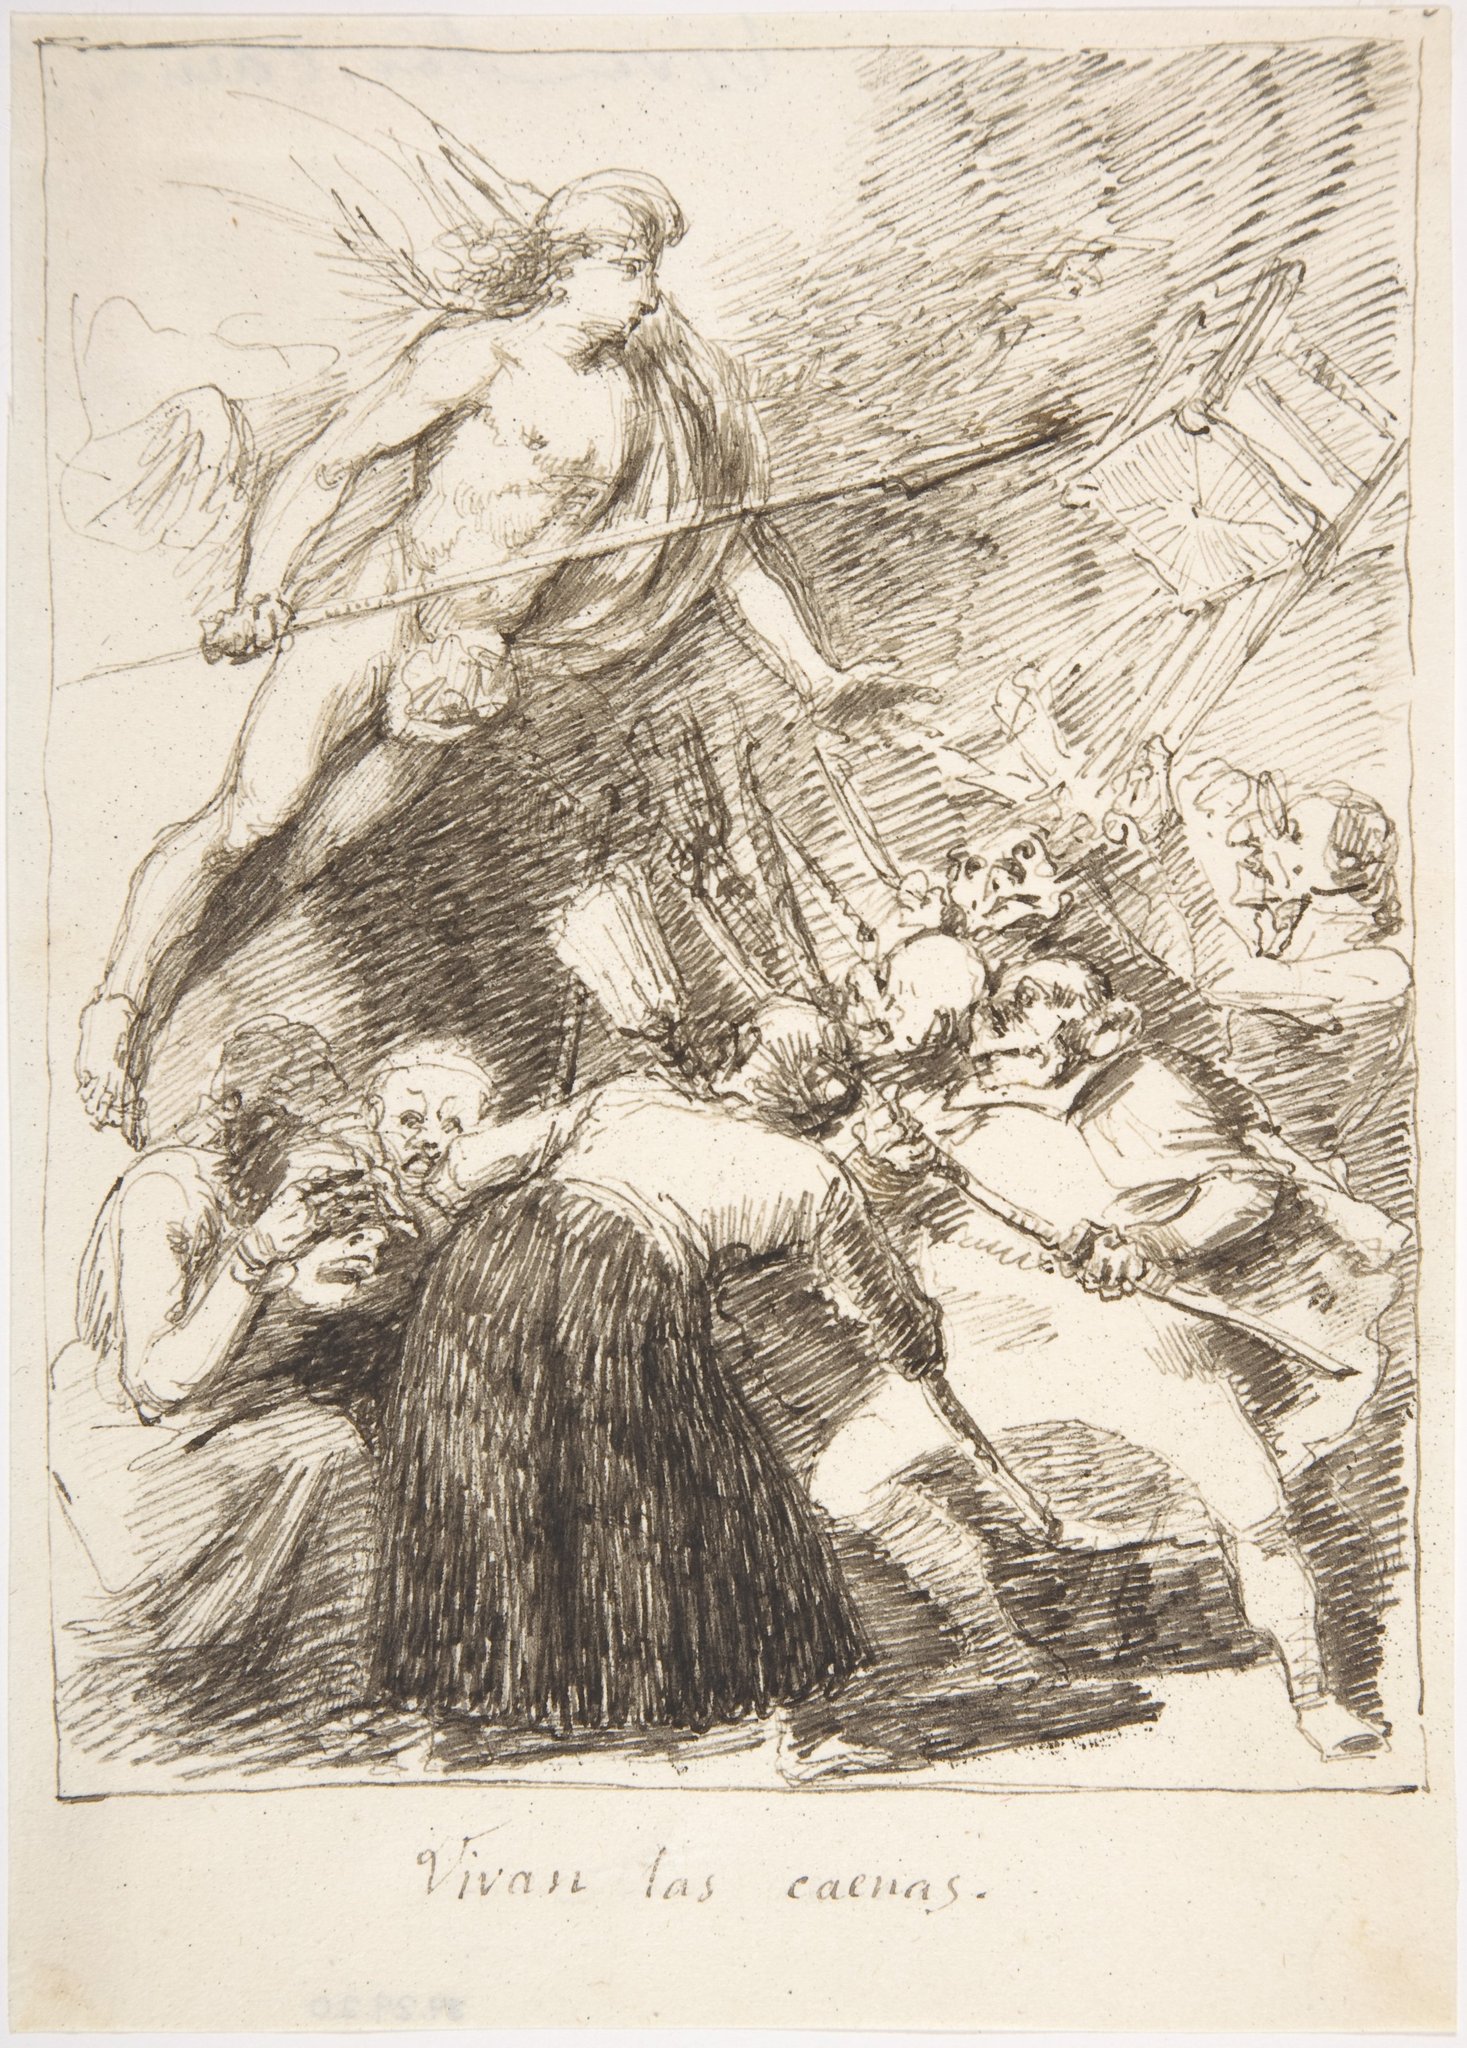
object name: drawing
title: Long Live the Chains! (Vivan las caenas [cadenas])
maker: leonardo alenza y nieto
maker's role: artist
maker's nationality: spanish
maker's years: 1807-1845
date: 1807-1845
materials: ink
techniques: pen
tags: spears,men,women